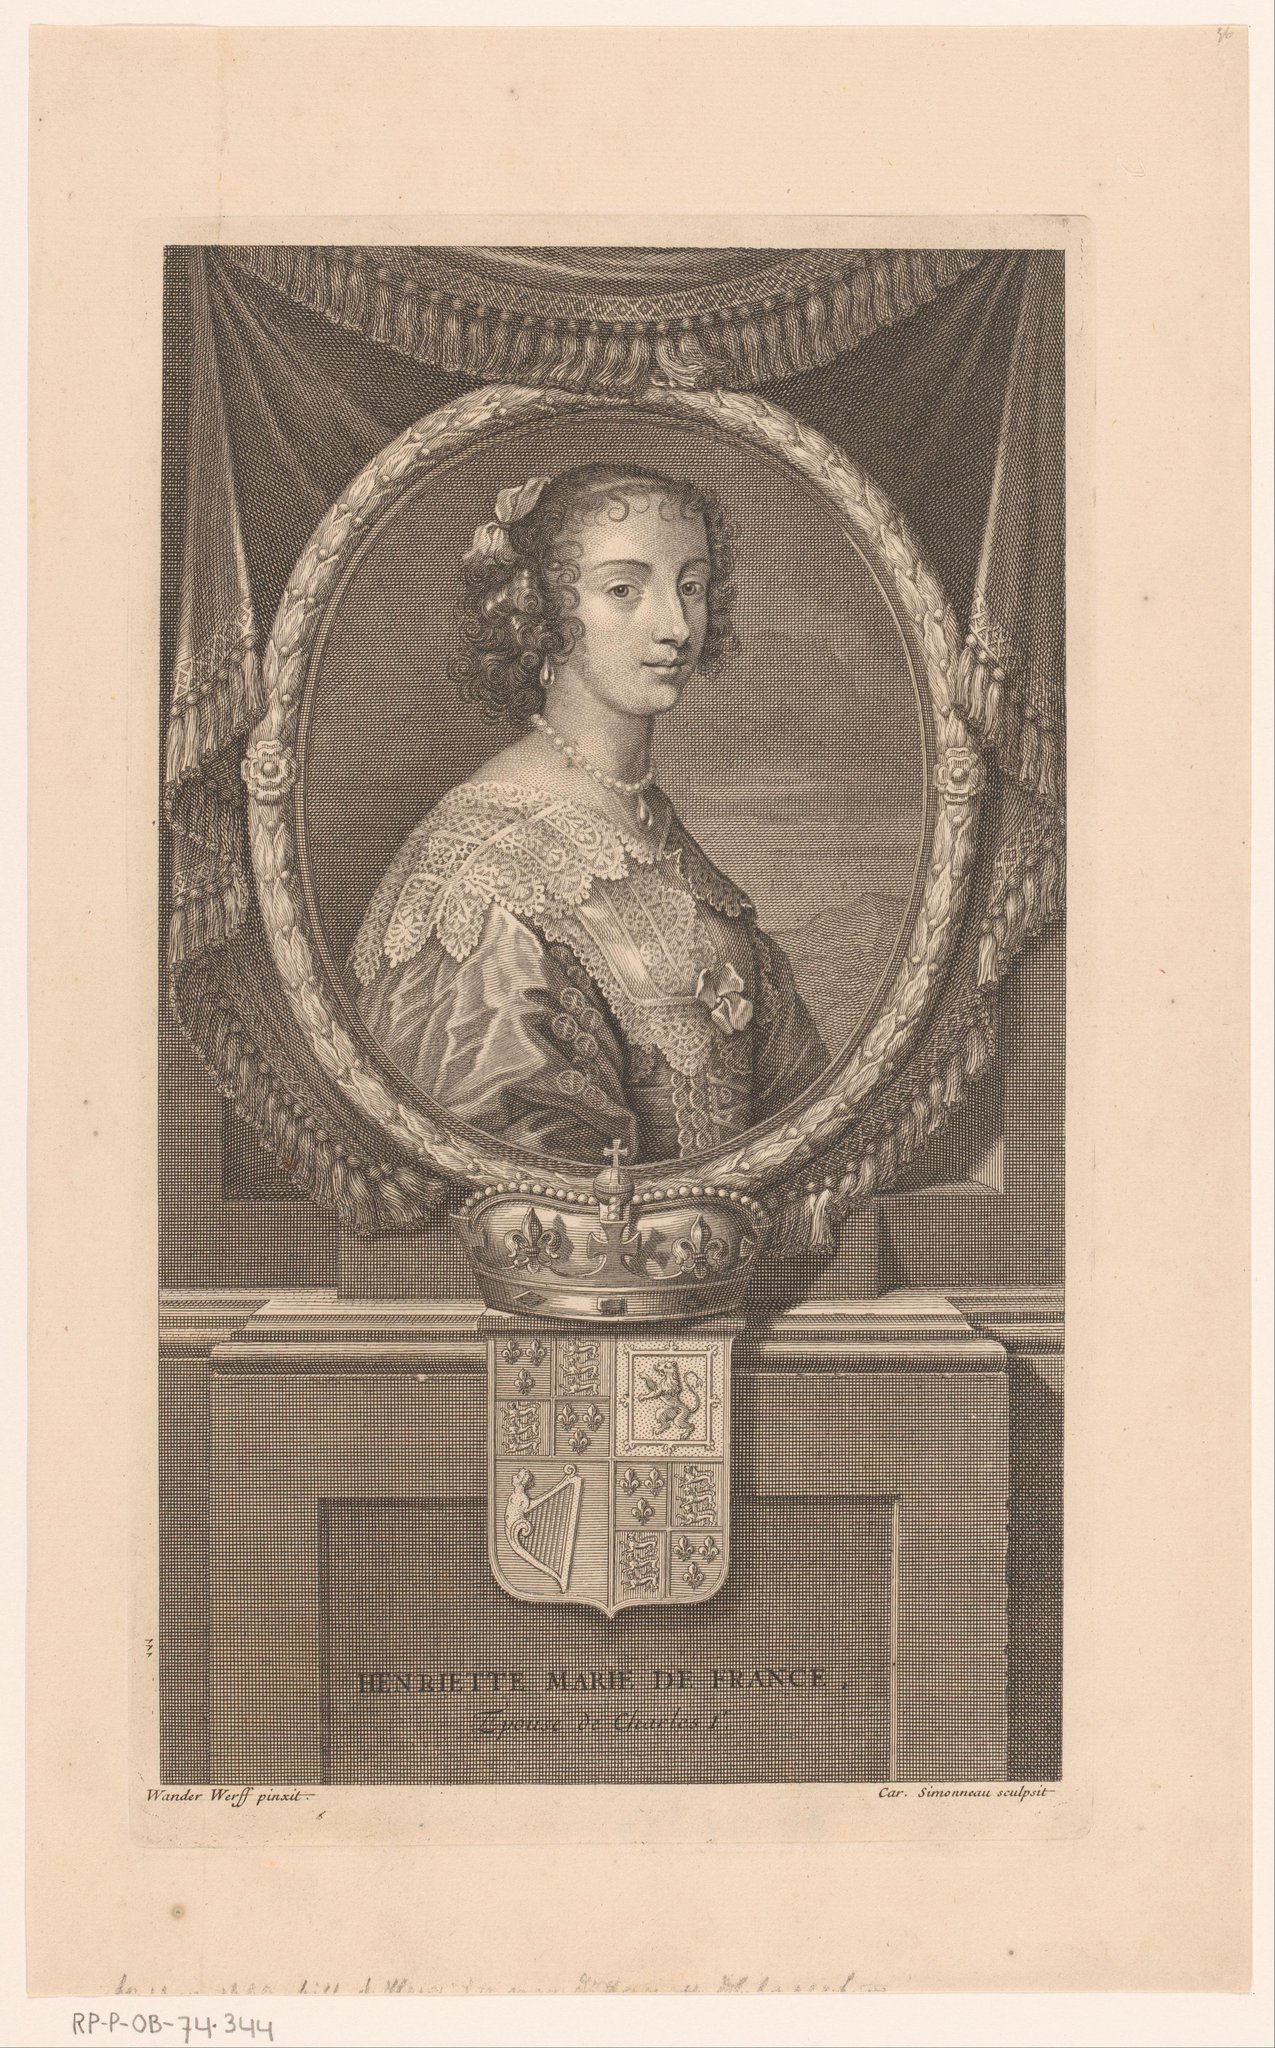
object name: print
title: Portret van Antoine Arnauld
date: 1694-1728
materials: paper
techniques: engraving, etching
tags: paris, brussels, historical persons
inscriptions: collector's mark: Lugt 2228